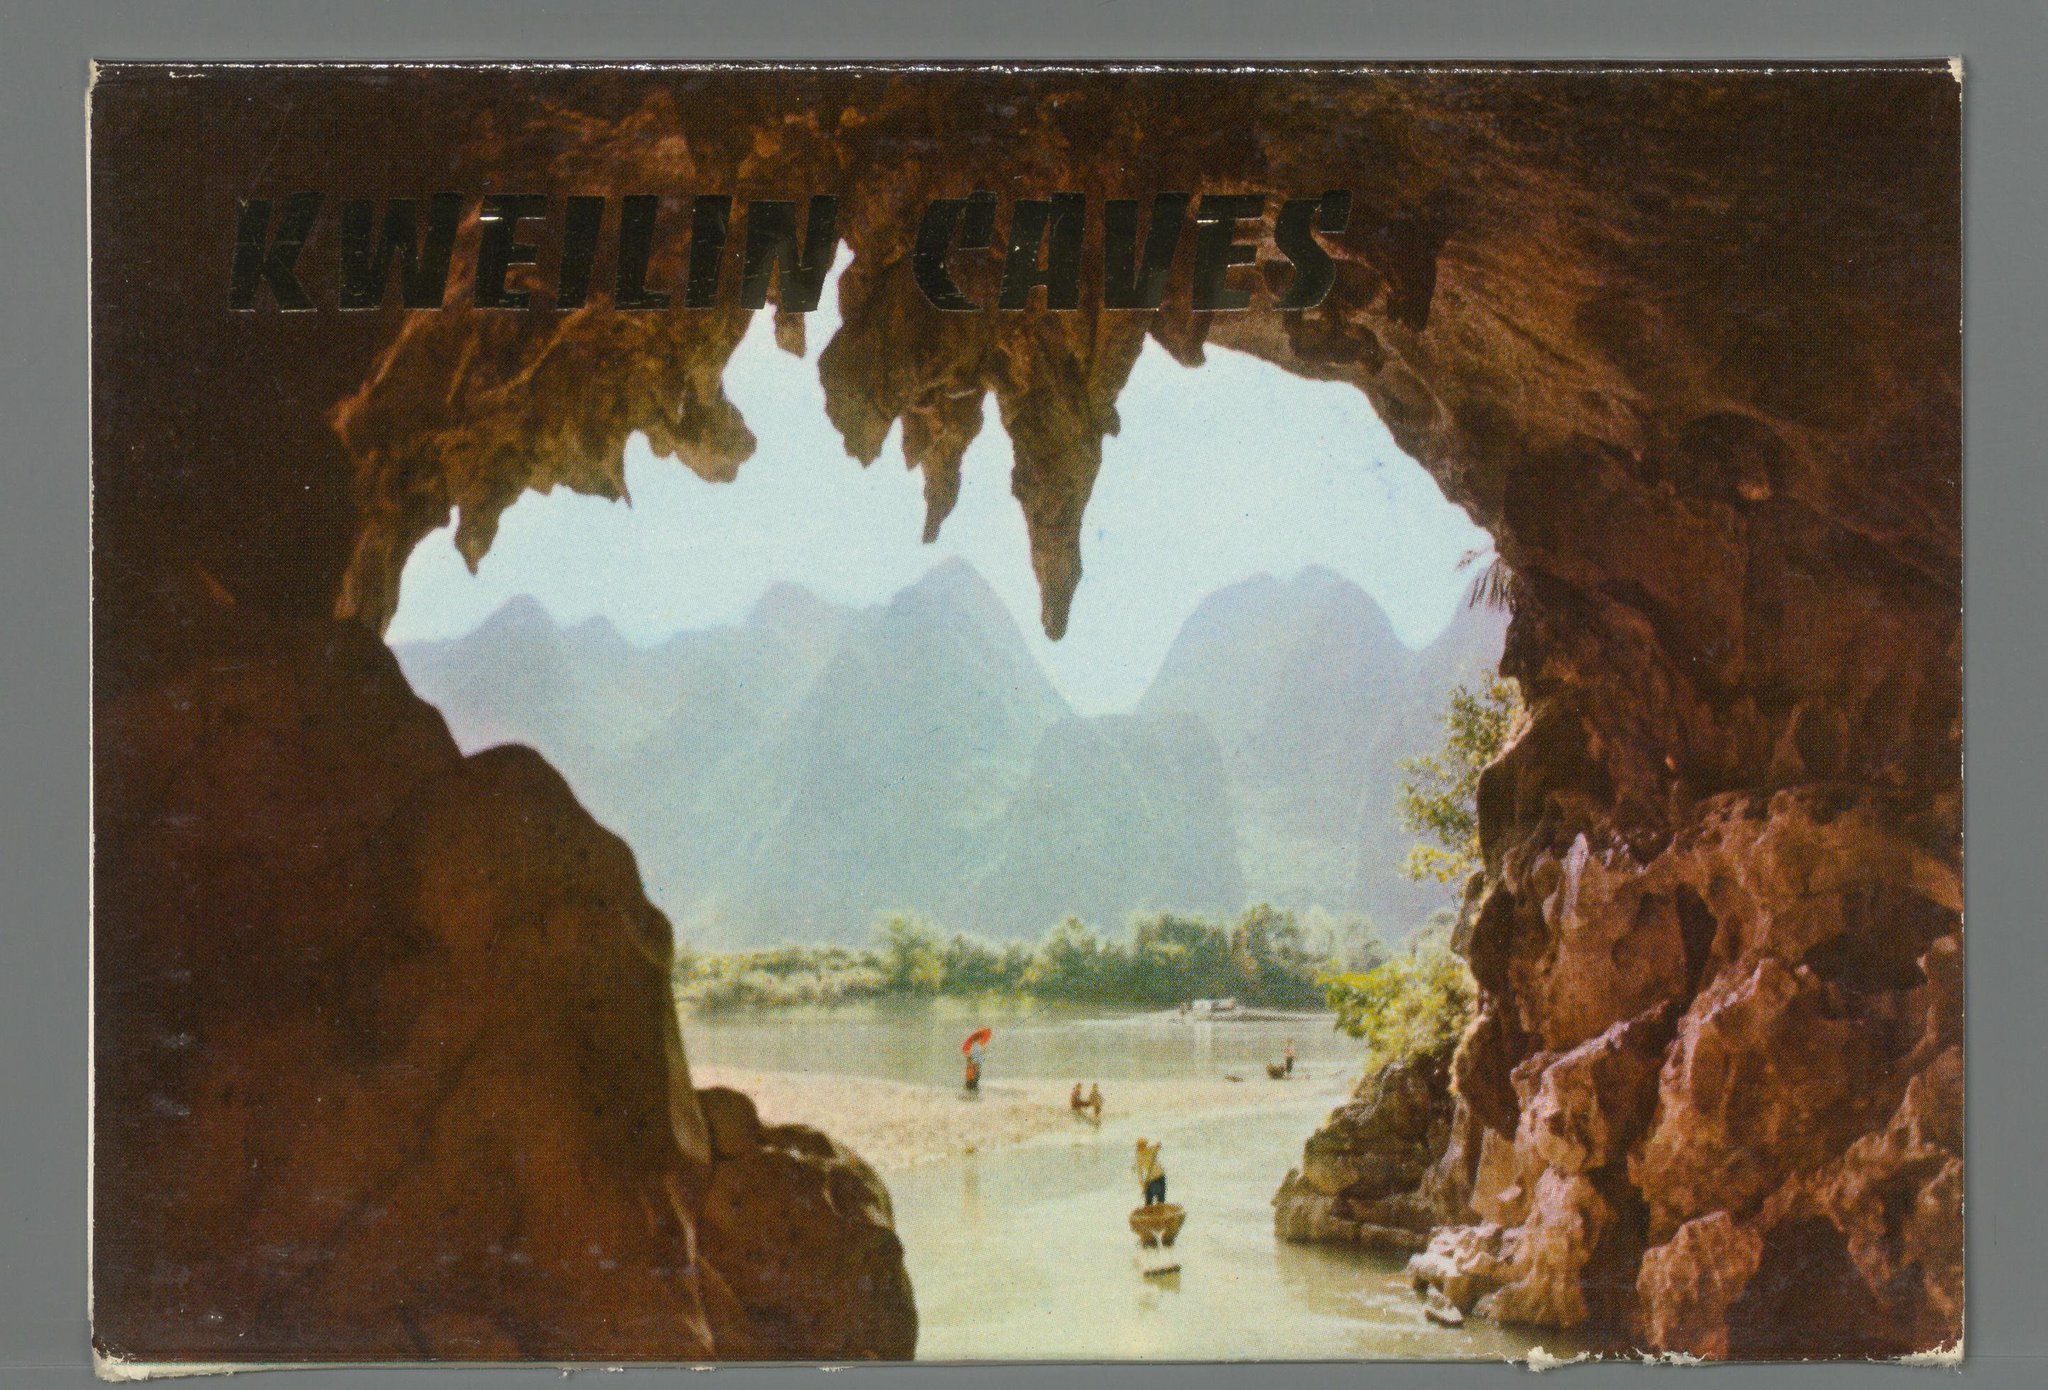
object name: photomechanical print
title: Omslag voor twaalf prentbriefkaarten met gezichten van de Guilin grotten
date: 1974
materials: cardboard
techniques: offset printed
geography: beijing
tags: stalactitic cave, river, mountains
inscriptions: date